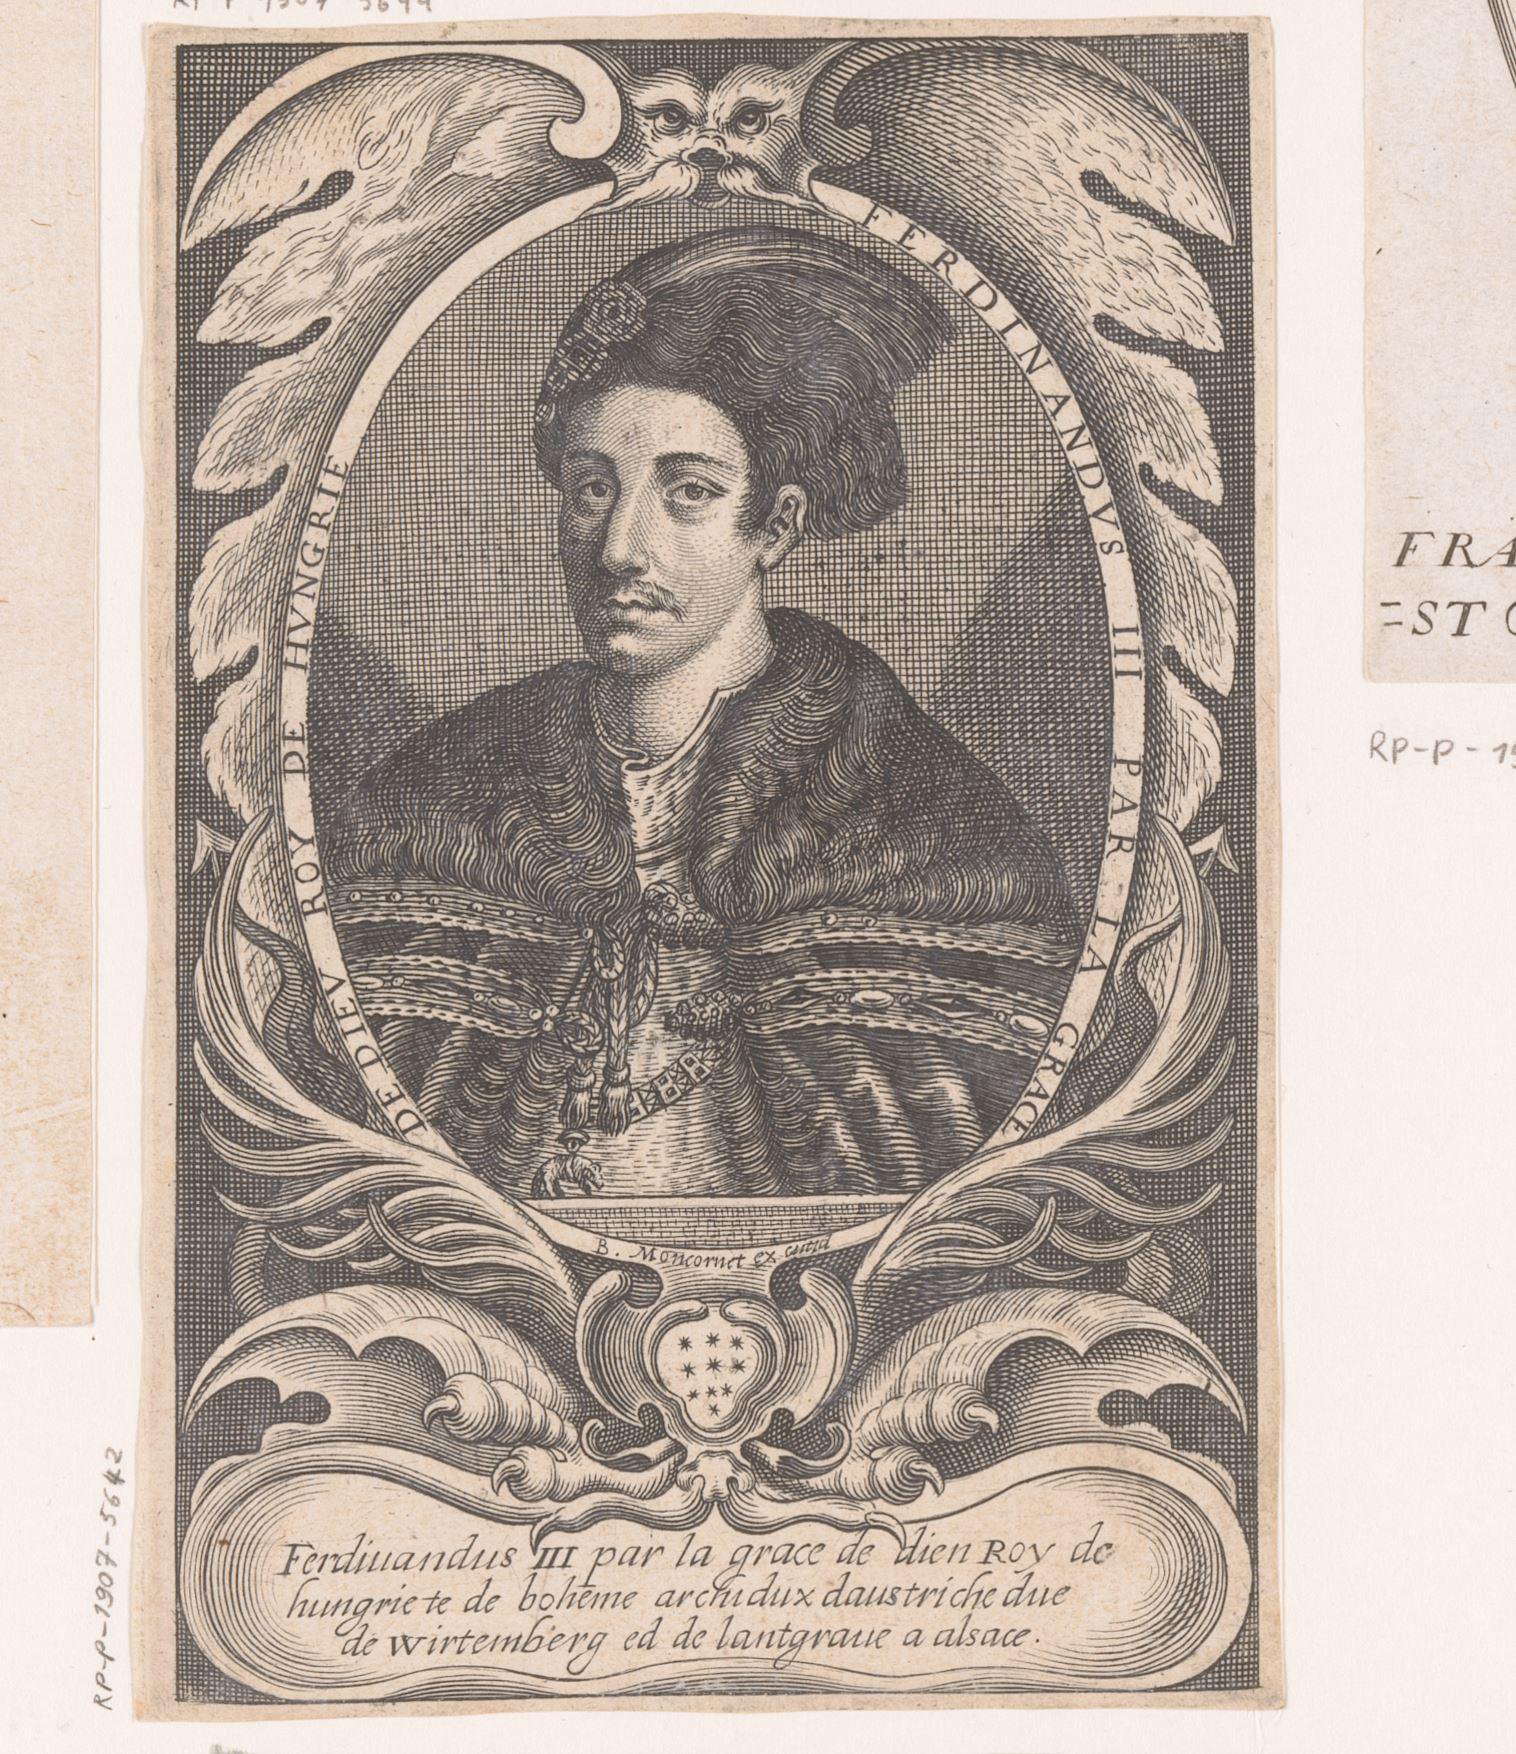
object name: print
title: Portret van keizer Ferdinand III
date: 1637-1668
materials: paper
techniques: engraving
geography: paris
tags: vienna, ferdinand iii (duits keizer), historical persons, emperor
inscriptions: collector's mark: Lugt 2228